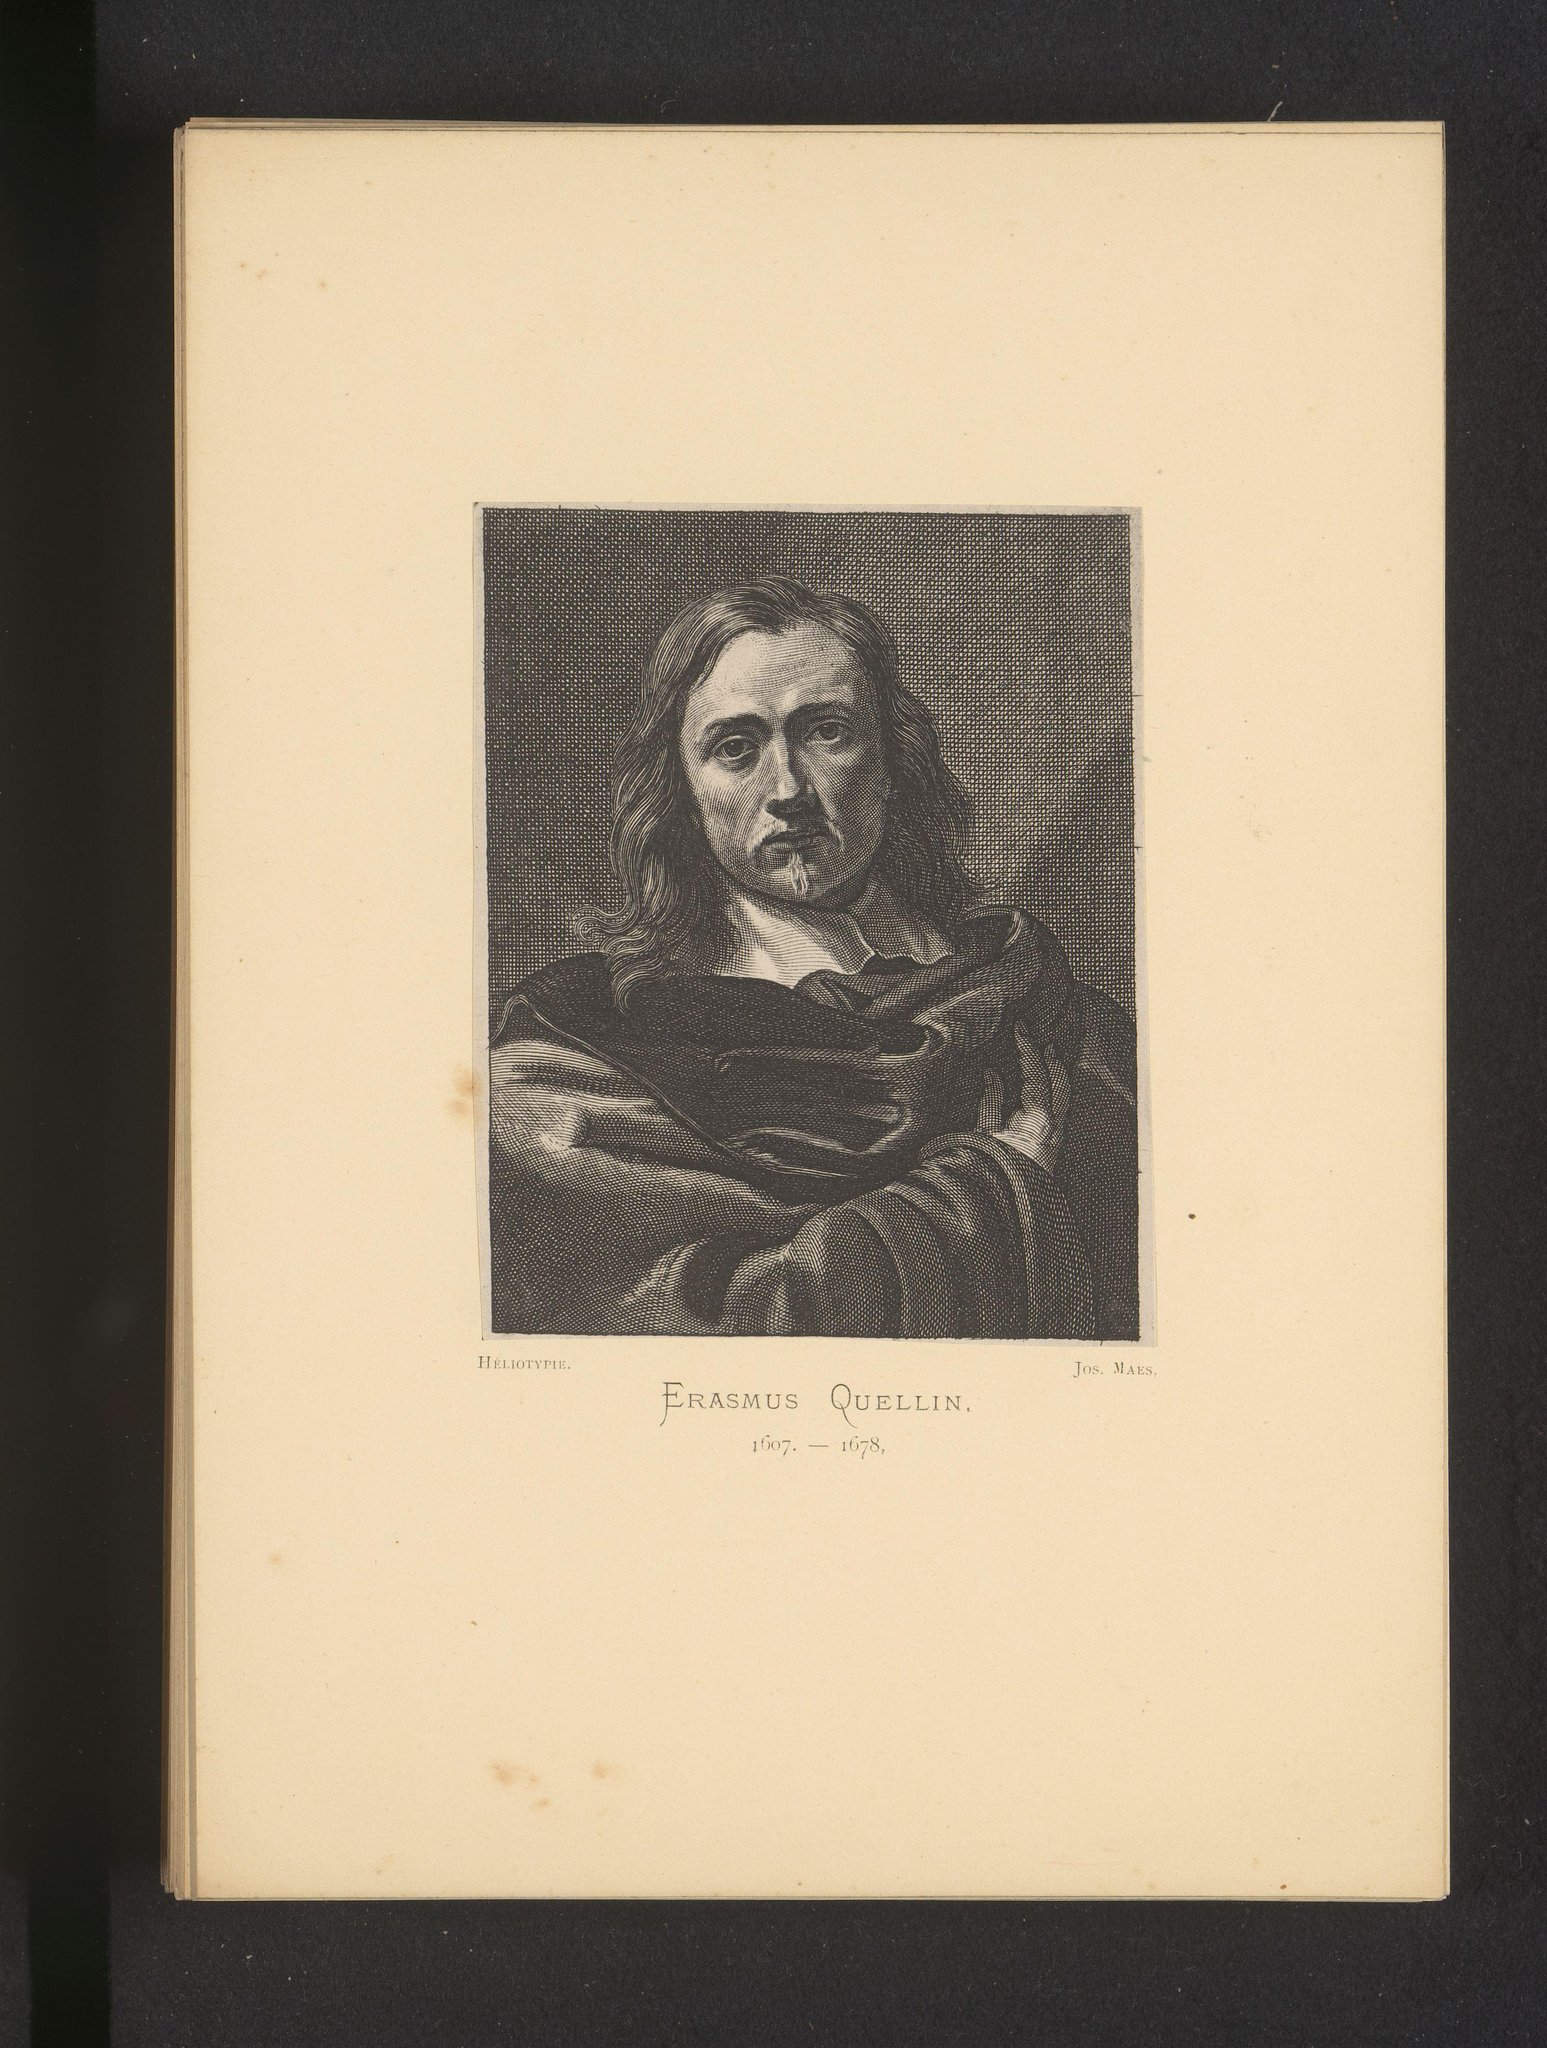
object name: photomechanical print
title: Erasmus Quellin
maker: joseph maes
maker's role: fotograaf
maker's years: 1838-1908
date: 1872-1877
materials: cardboard, paper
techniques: photograph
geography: antwerp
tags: antwerp, draughtsman, erasmus quellinus (ii), historical persons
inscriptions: inscription: ‘1607. - 1678.’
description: Deze prent maakt deel uit van een omslag met 150 prenten en een katern met een lijst van afbeeldingen.